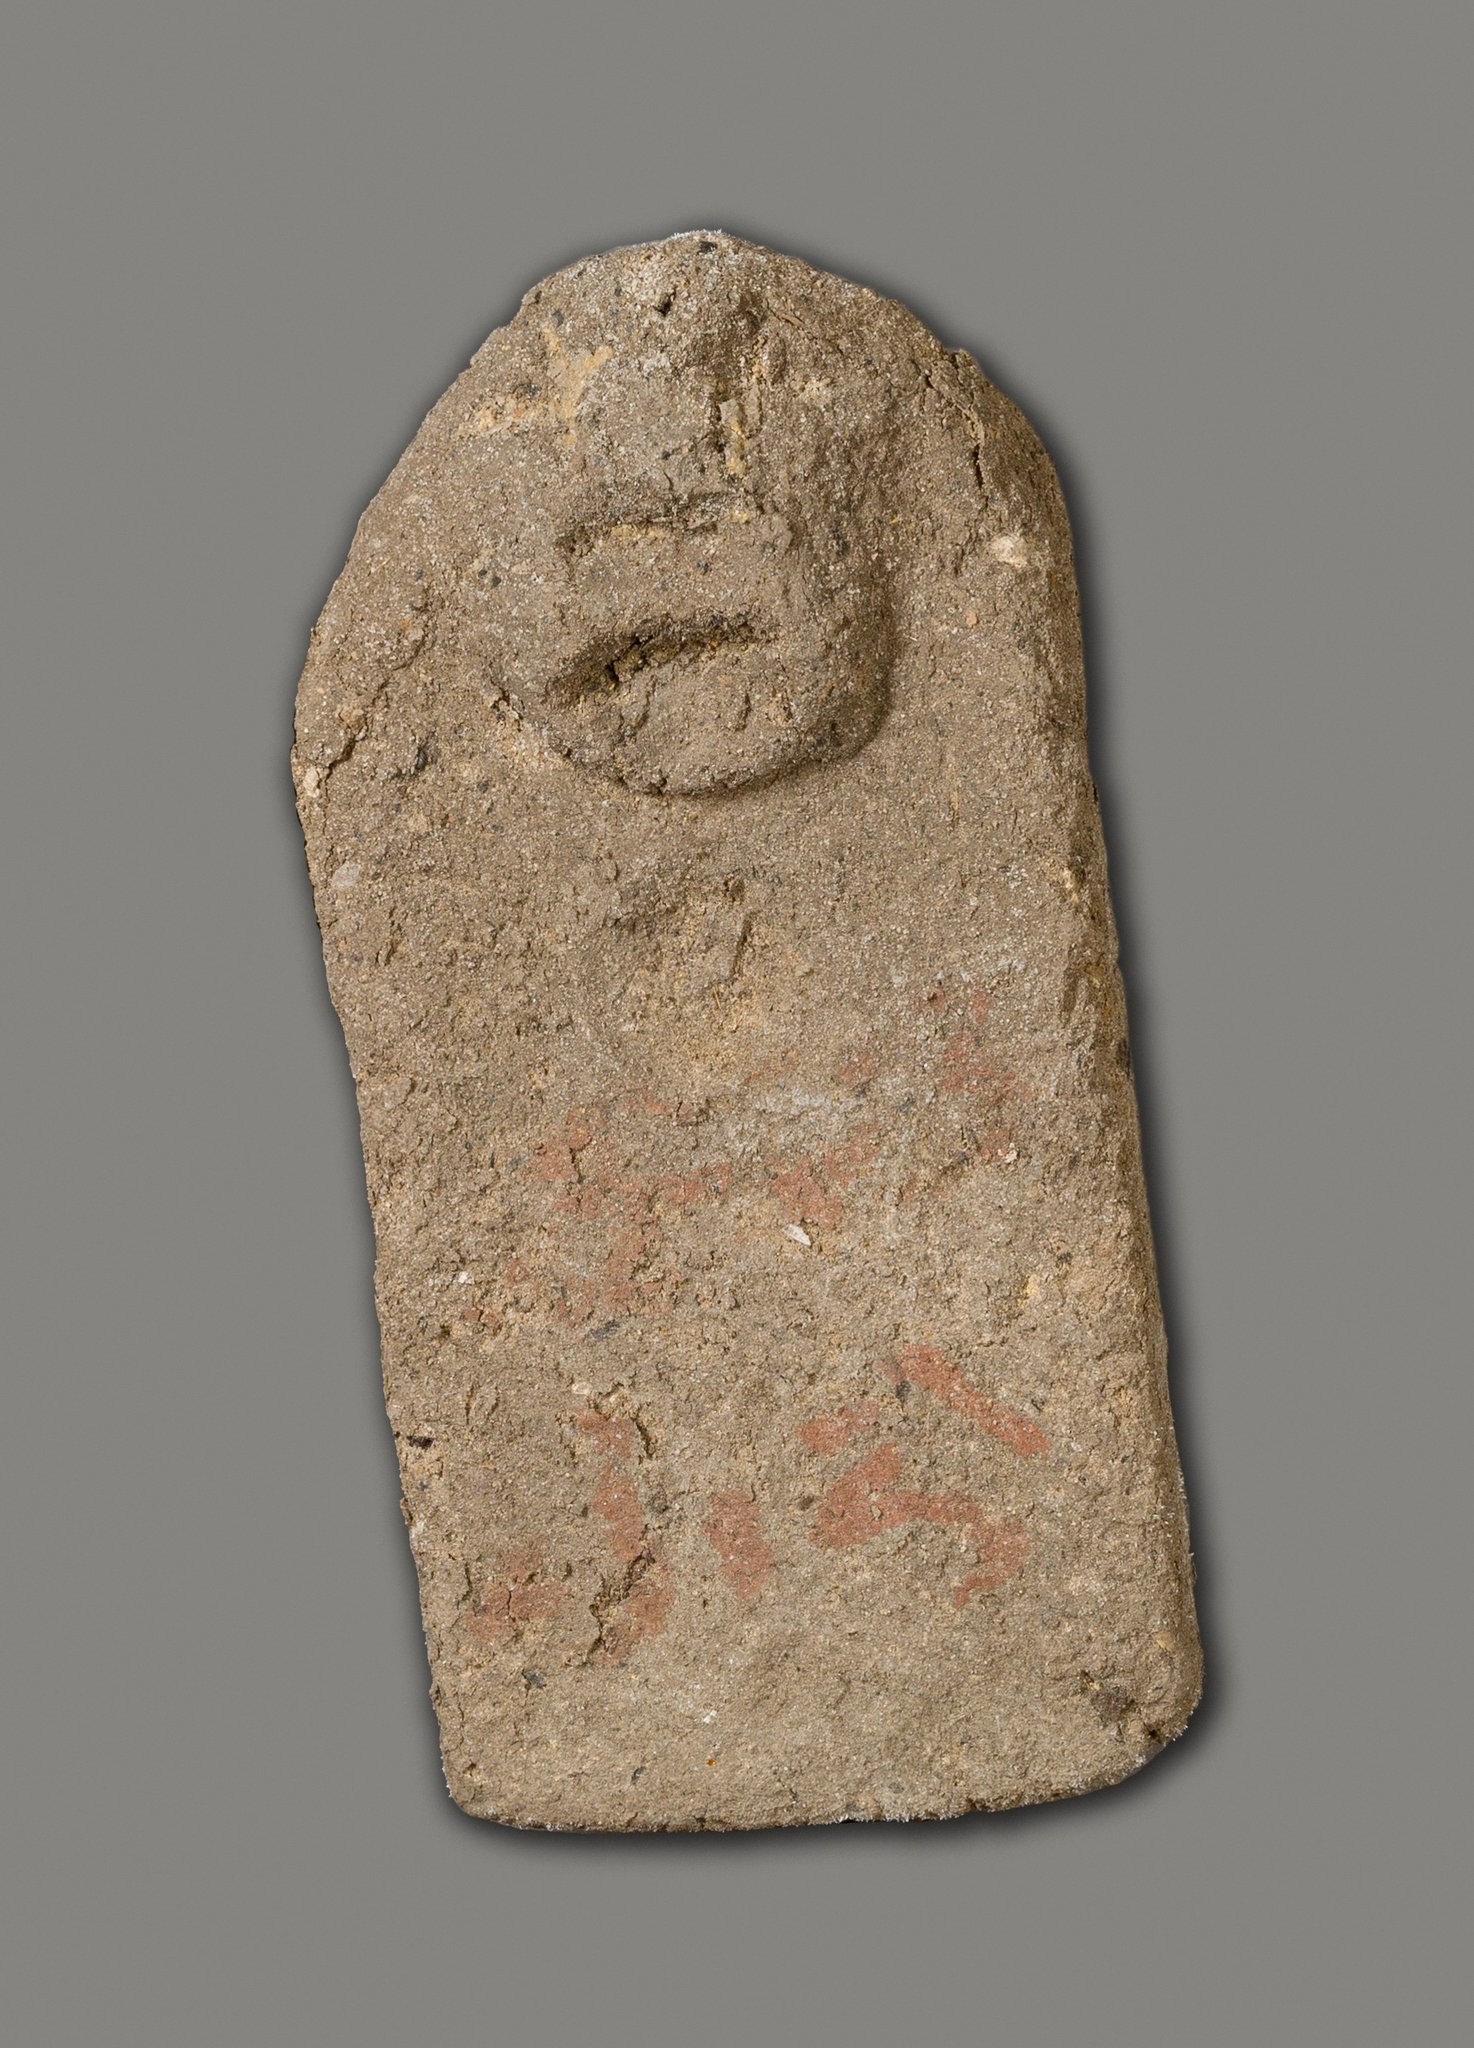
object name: figure, magical, execration, tablet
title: Magical Figure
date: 1802-1550 BCE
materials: clay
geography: egypt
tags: faces